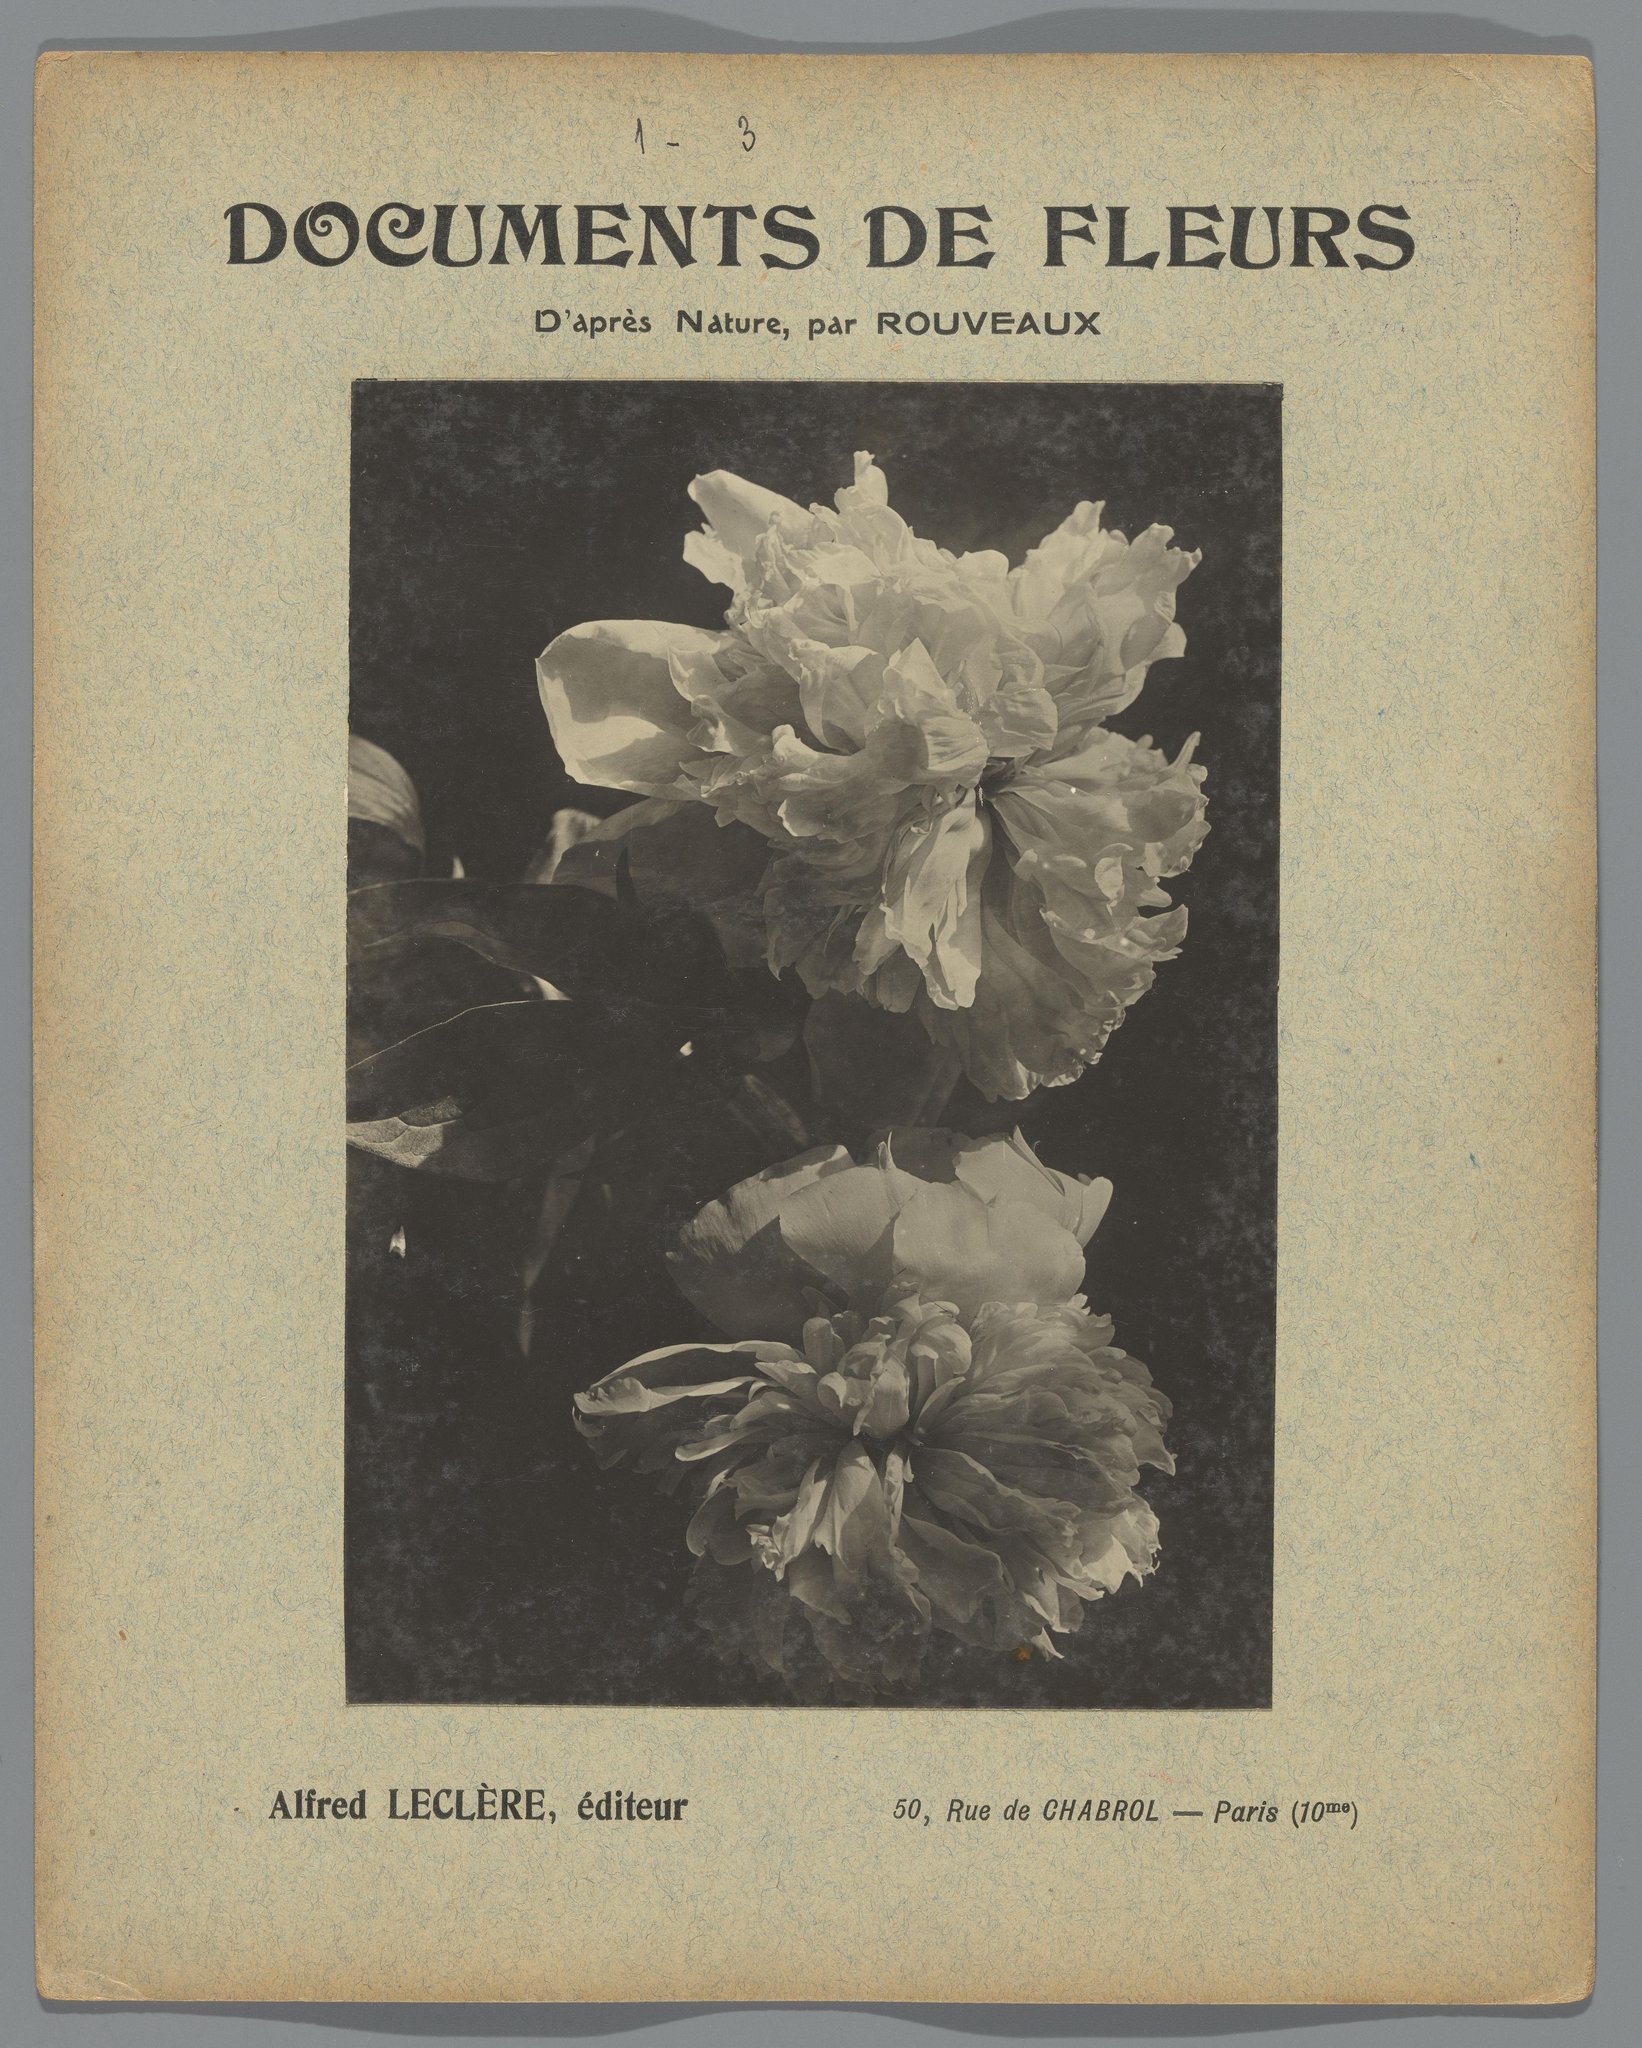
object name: photograph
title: Bloemstudie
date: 1895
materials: photographic support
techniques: gelatin silver print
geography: france